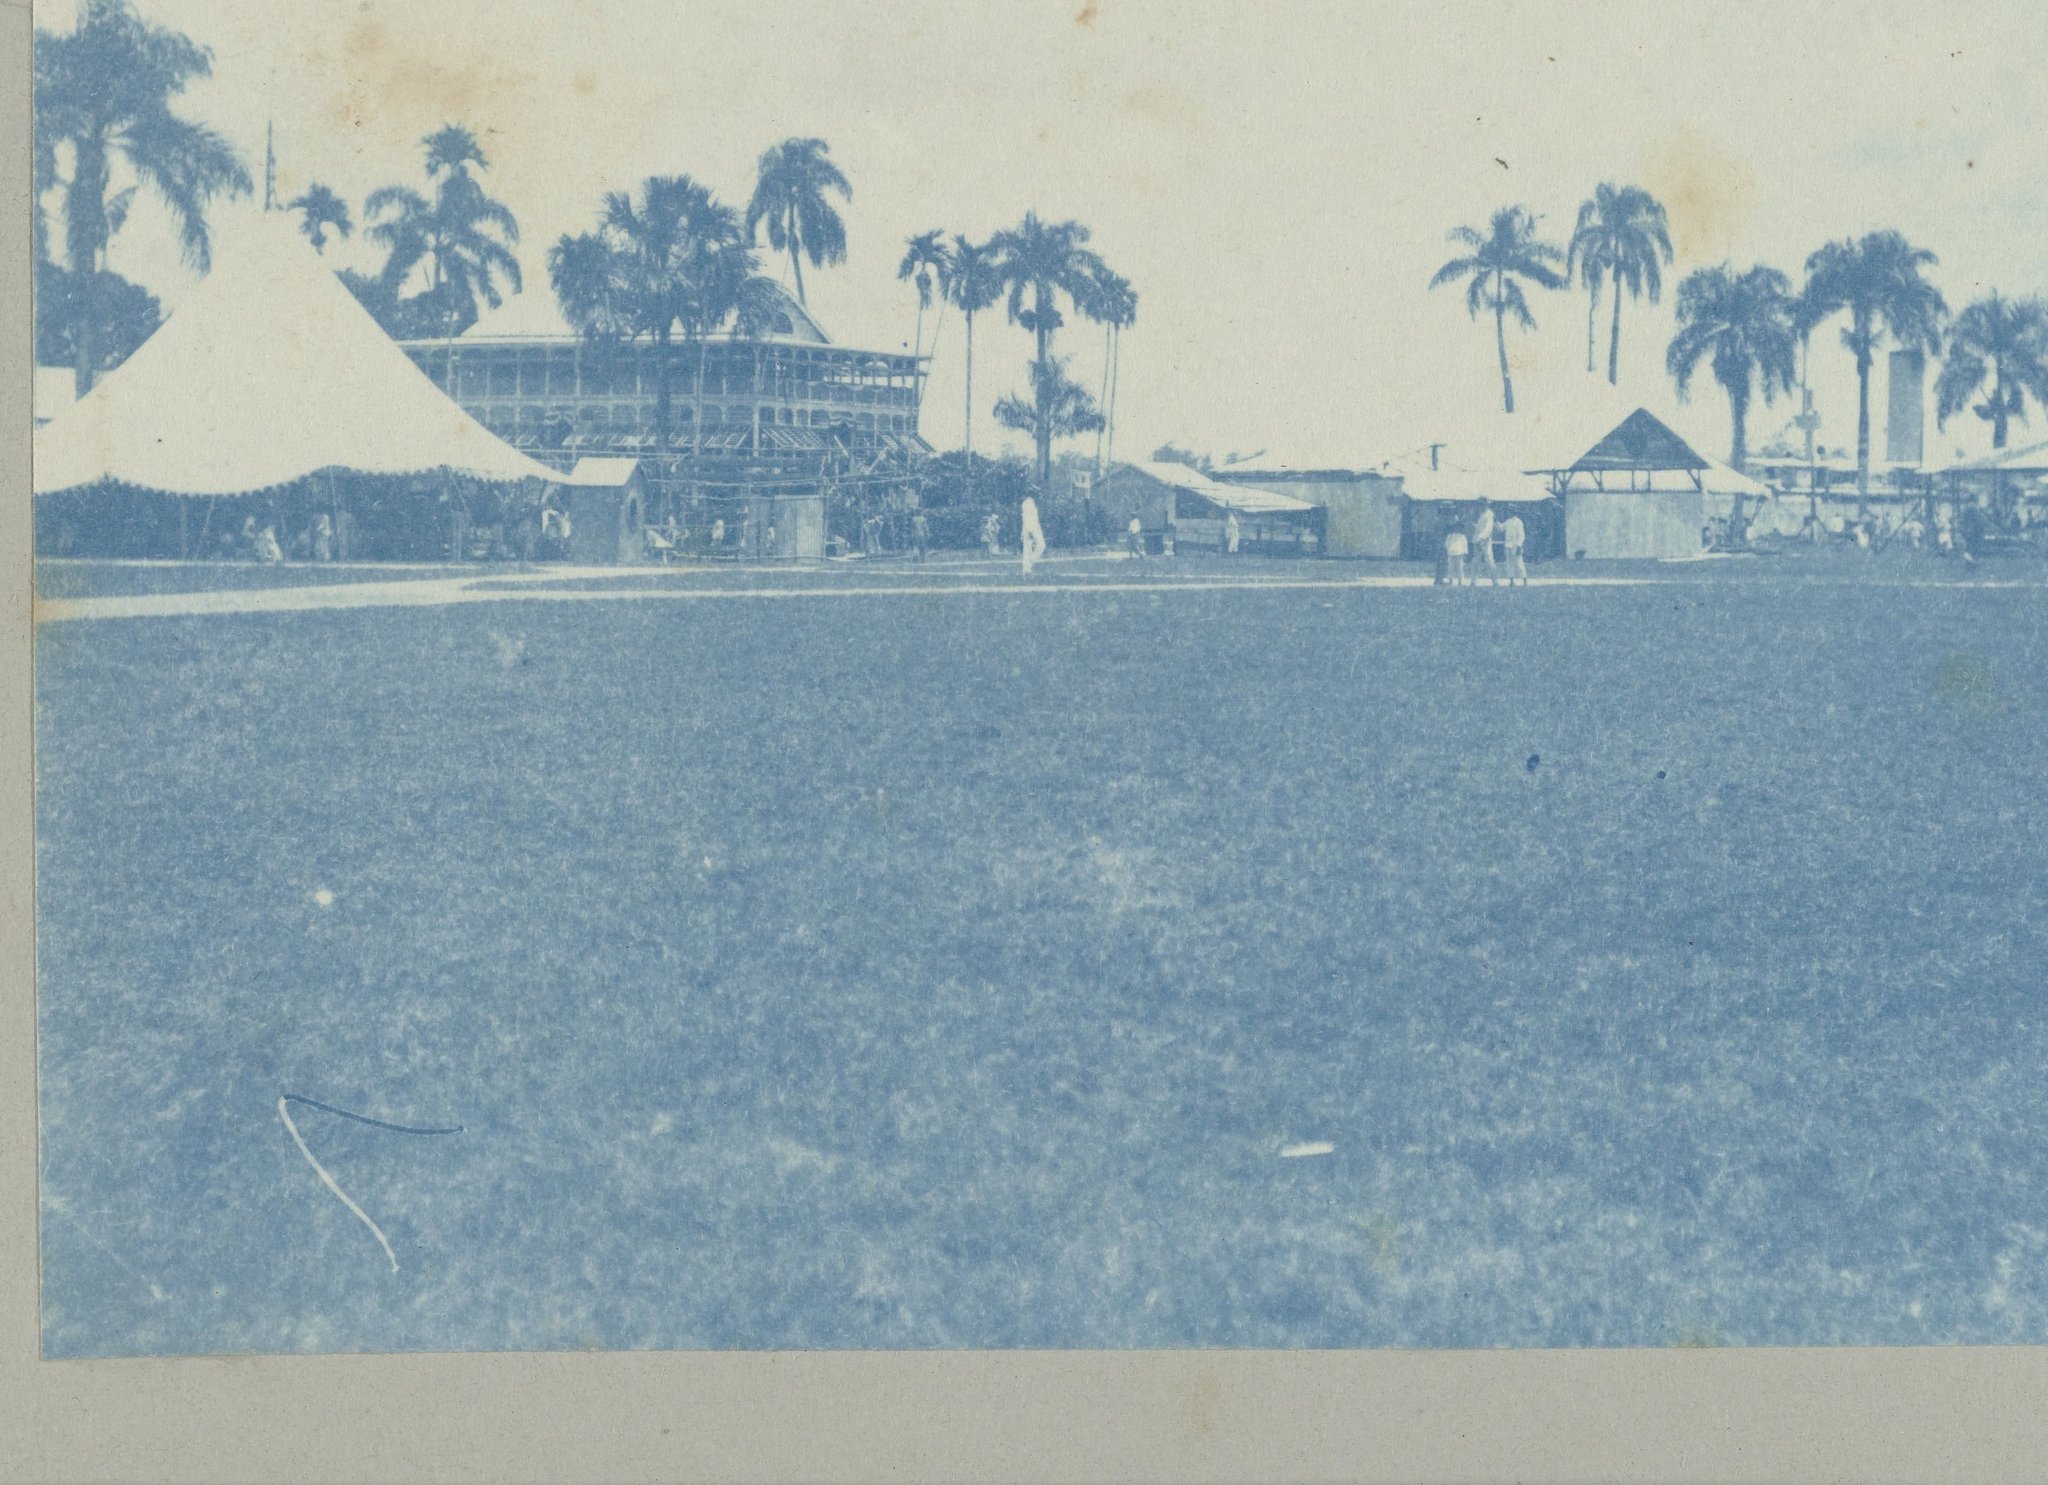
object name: photograph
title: Koninginnedag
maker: hendrik doijer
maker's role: engineer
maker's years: 1863-1925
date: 1903-1910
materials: photographic support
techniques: cyanotype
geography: suriname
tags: suriname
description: Park met tenten, feestelijkheden tijdens de viering van Koninginnedag op 31 augustus te Paramaribo. Onderdeel van het fotoalbum Souvenir de Voyage (deel 2), over het leven van de familie Doijer in en rond de plantage Ma Retraite in Suriname in de jaren 1903-1910.